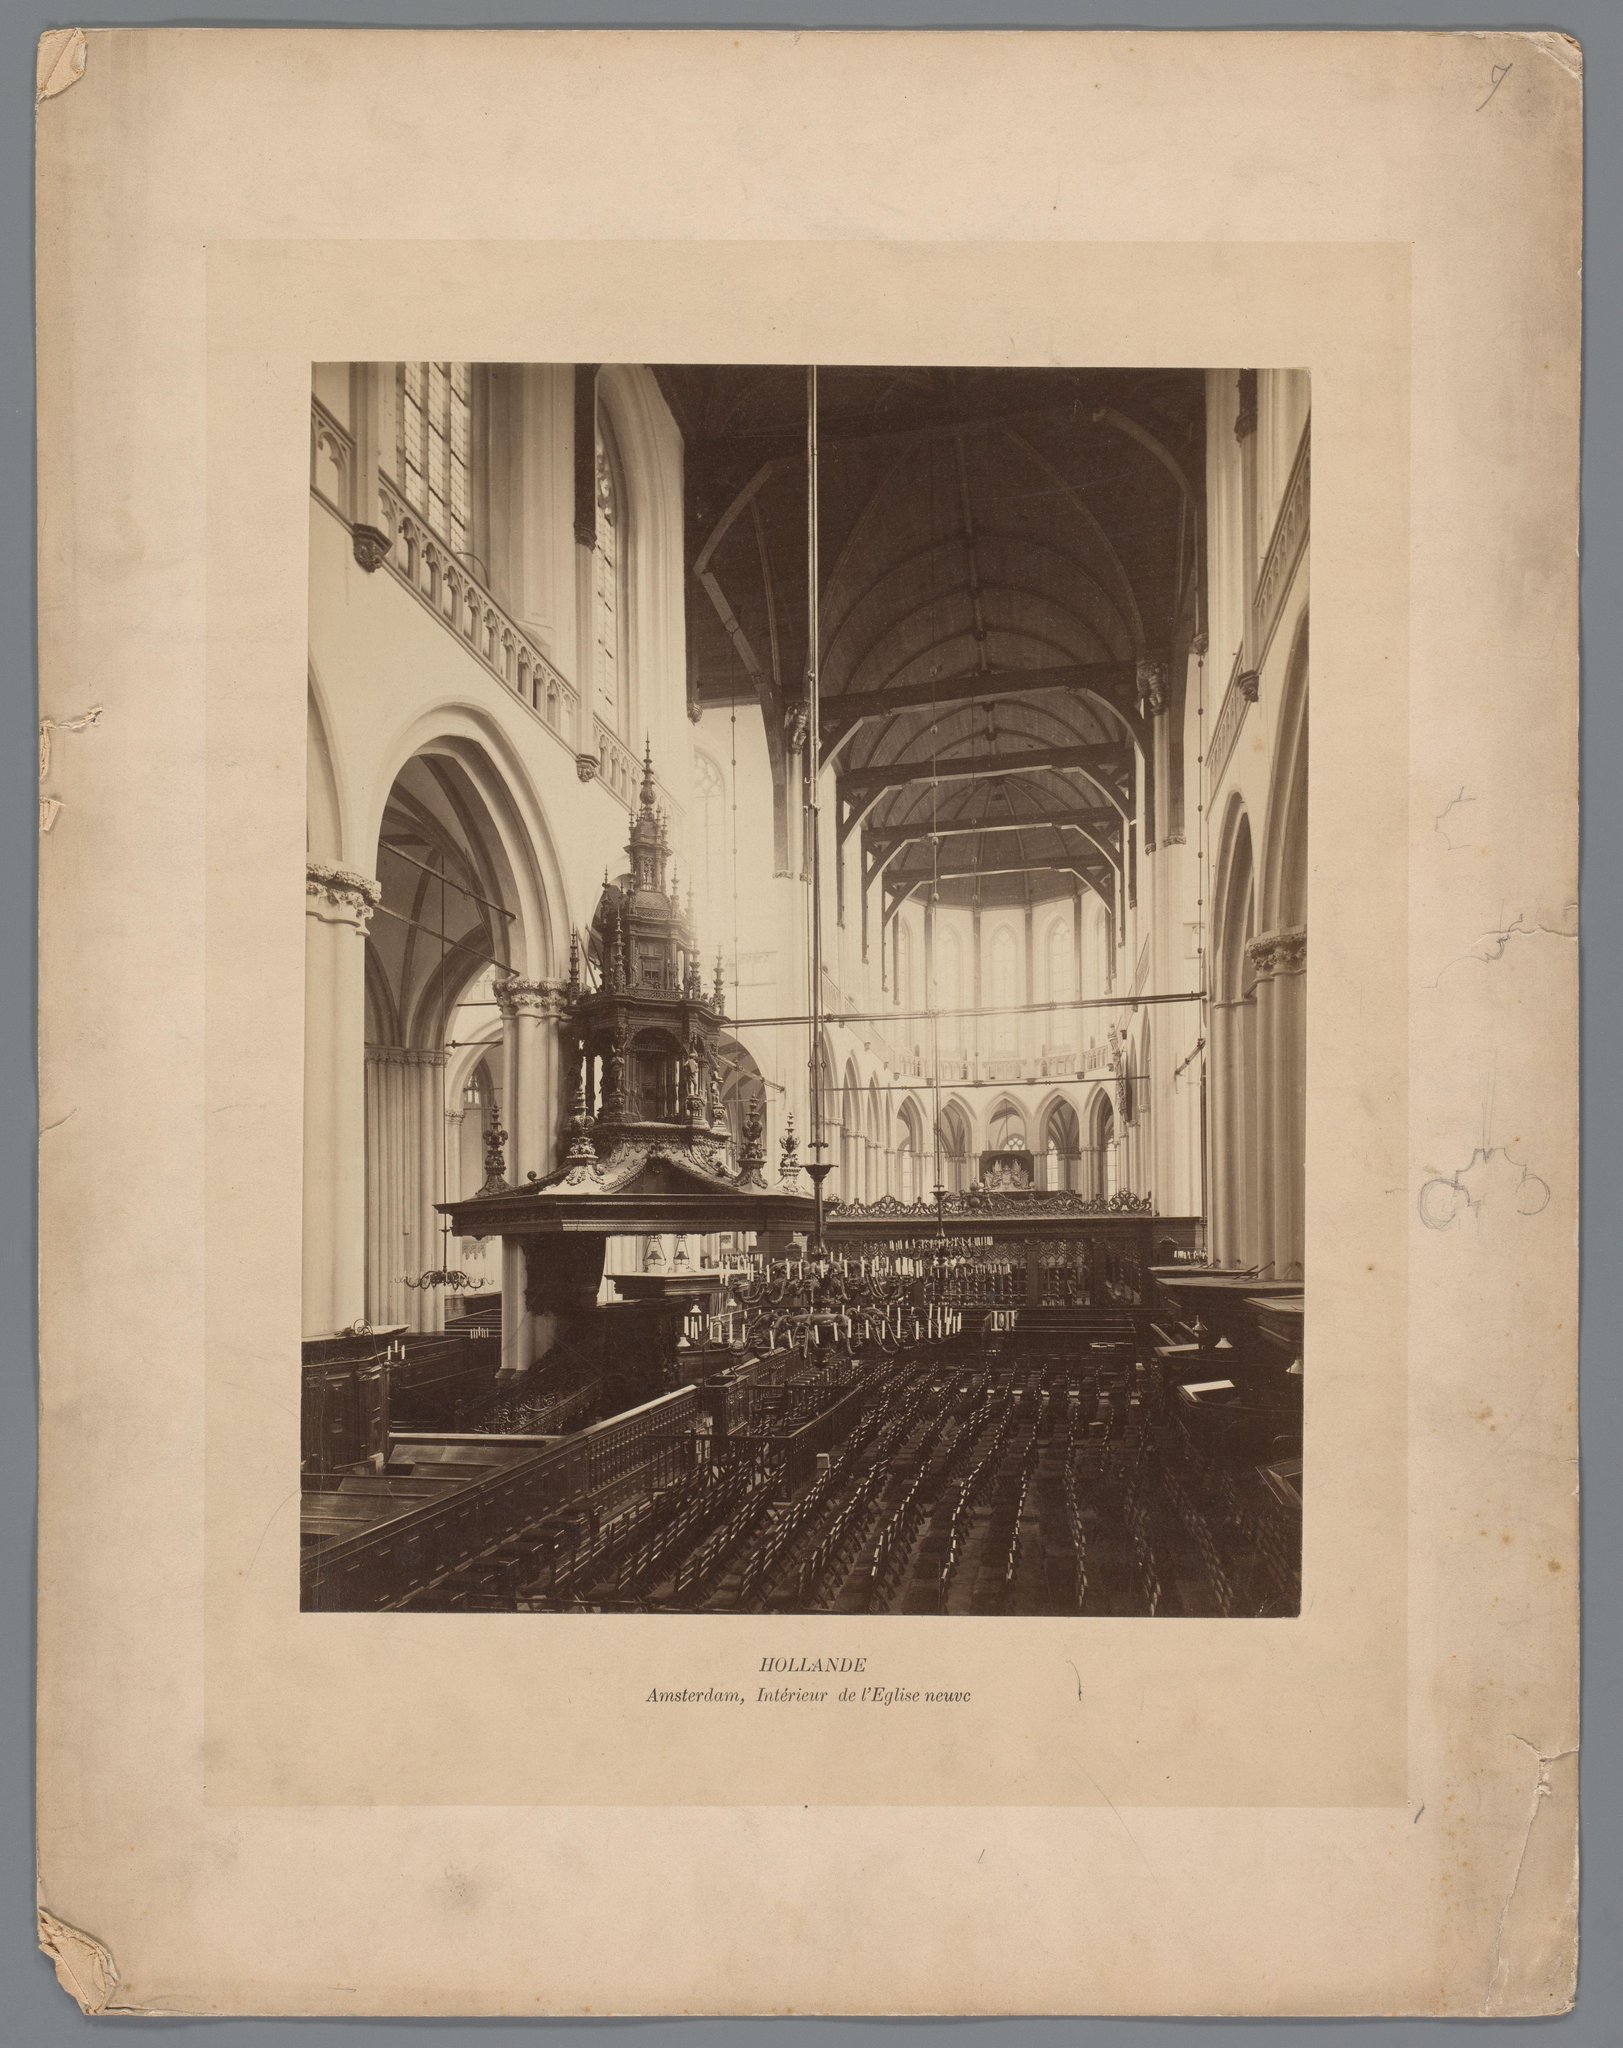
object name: photograph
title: Interieur van de Nieuwe Kerk in Amsterdam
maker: Anonymous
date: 1850-1880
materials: cardboard, paper, photographic support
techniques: albumen print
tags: interior of church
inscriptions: stamp: ‘ryksschool voor kunstnijverheid Groep’